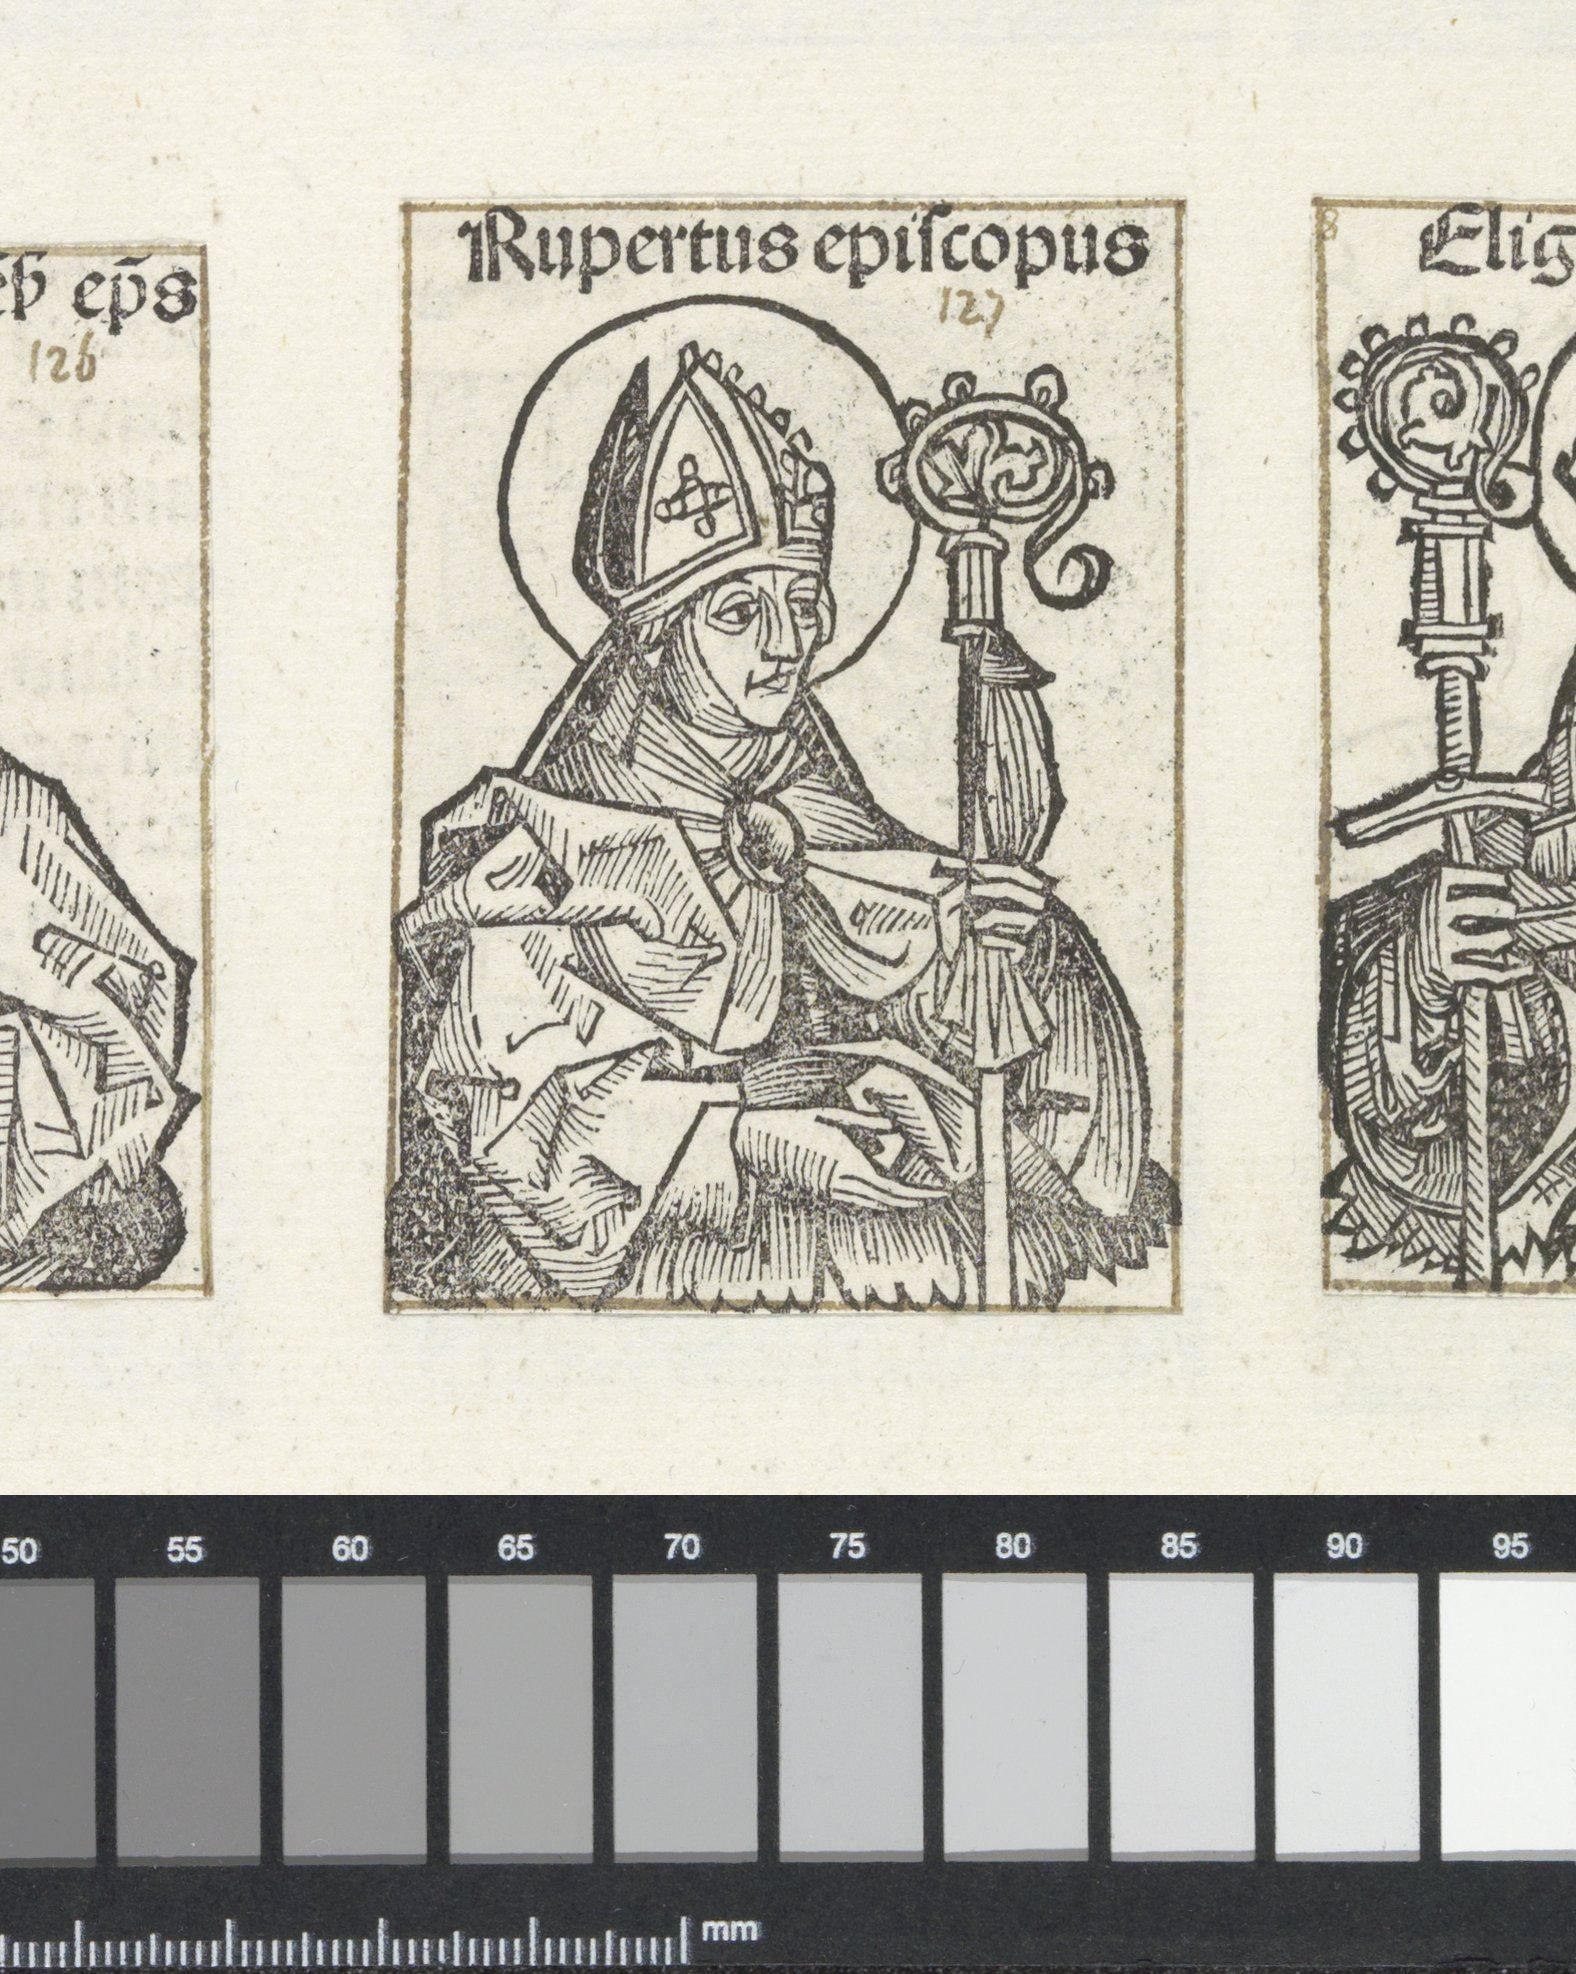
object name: print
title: Rupert van Salzburg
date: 1493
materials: paper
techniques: letterpress printing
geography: nuremberg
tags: archbishop, bishop, etc. (roman catholic)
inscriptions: inscription: ‘127’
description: De houtsnede wordt herhaaldelijk gebruikt als boekillustratie in de Liber Chronicarum (of Neurenbergkroniek) van Hartmann Schedel, verschenen in het Latijn en Duits in 1493. Zie de Latijnse uitgave, folio 152r.